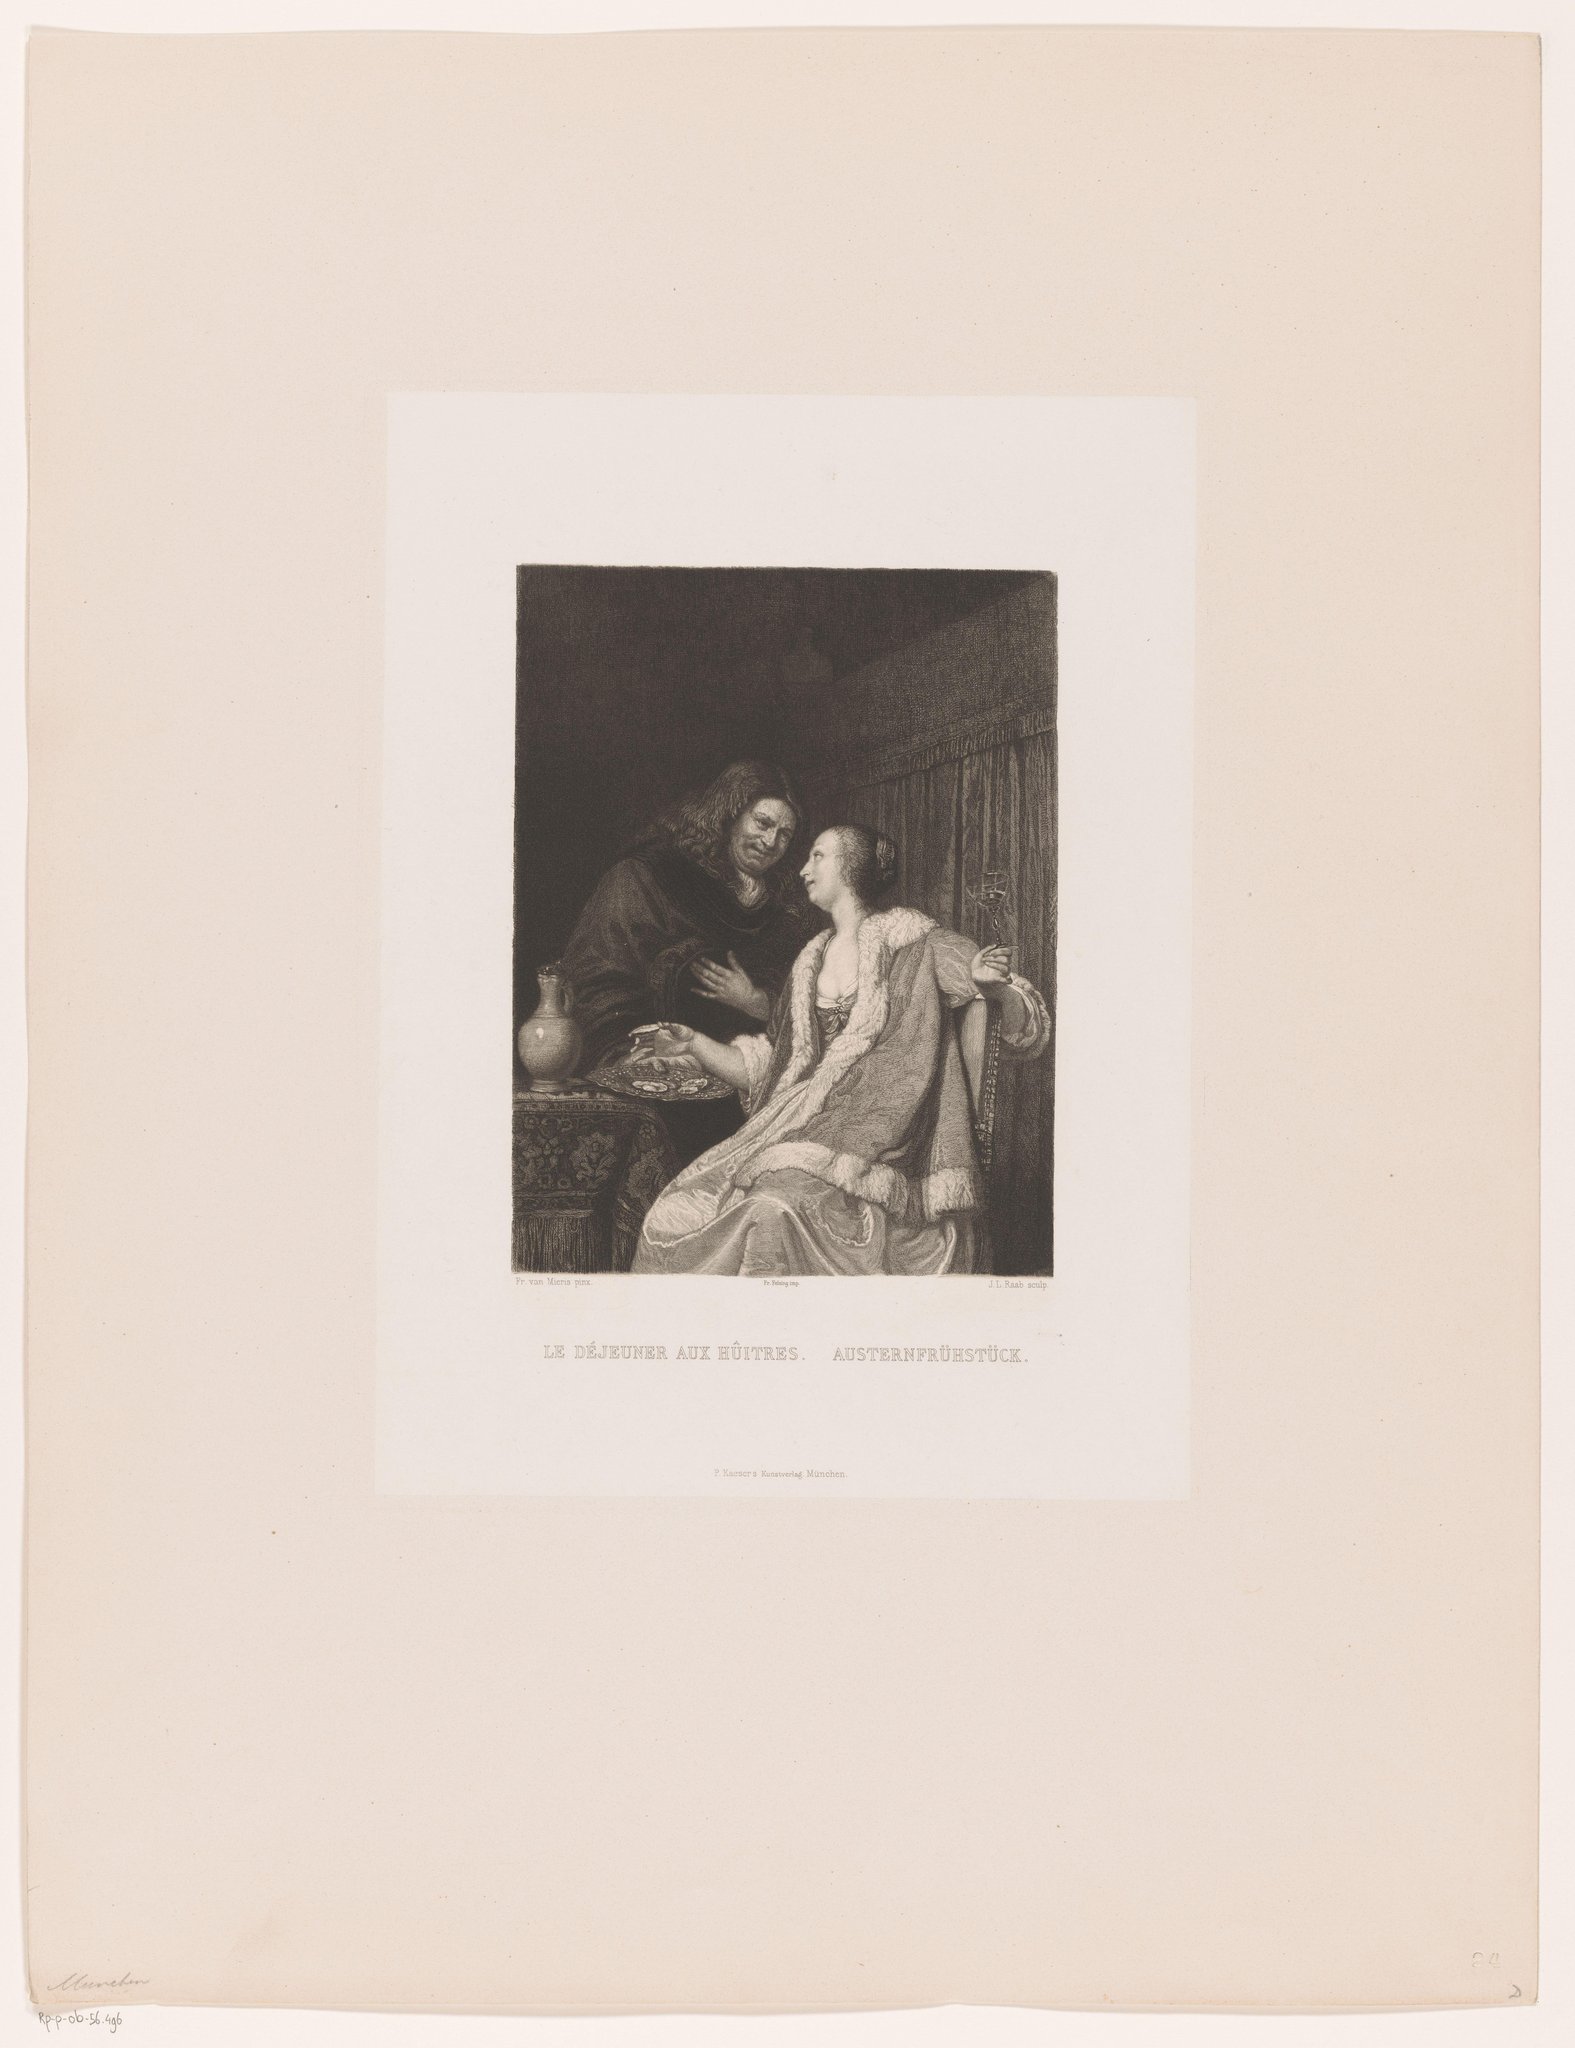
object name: print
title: Le déjeuner aux hûitres / Austernfrühstück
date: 1835-1899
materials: paper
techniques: etching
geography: munich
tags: breakfast, molluscs: oyster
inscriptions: number: ‘24’, collector's mark: Lugt 2228